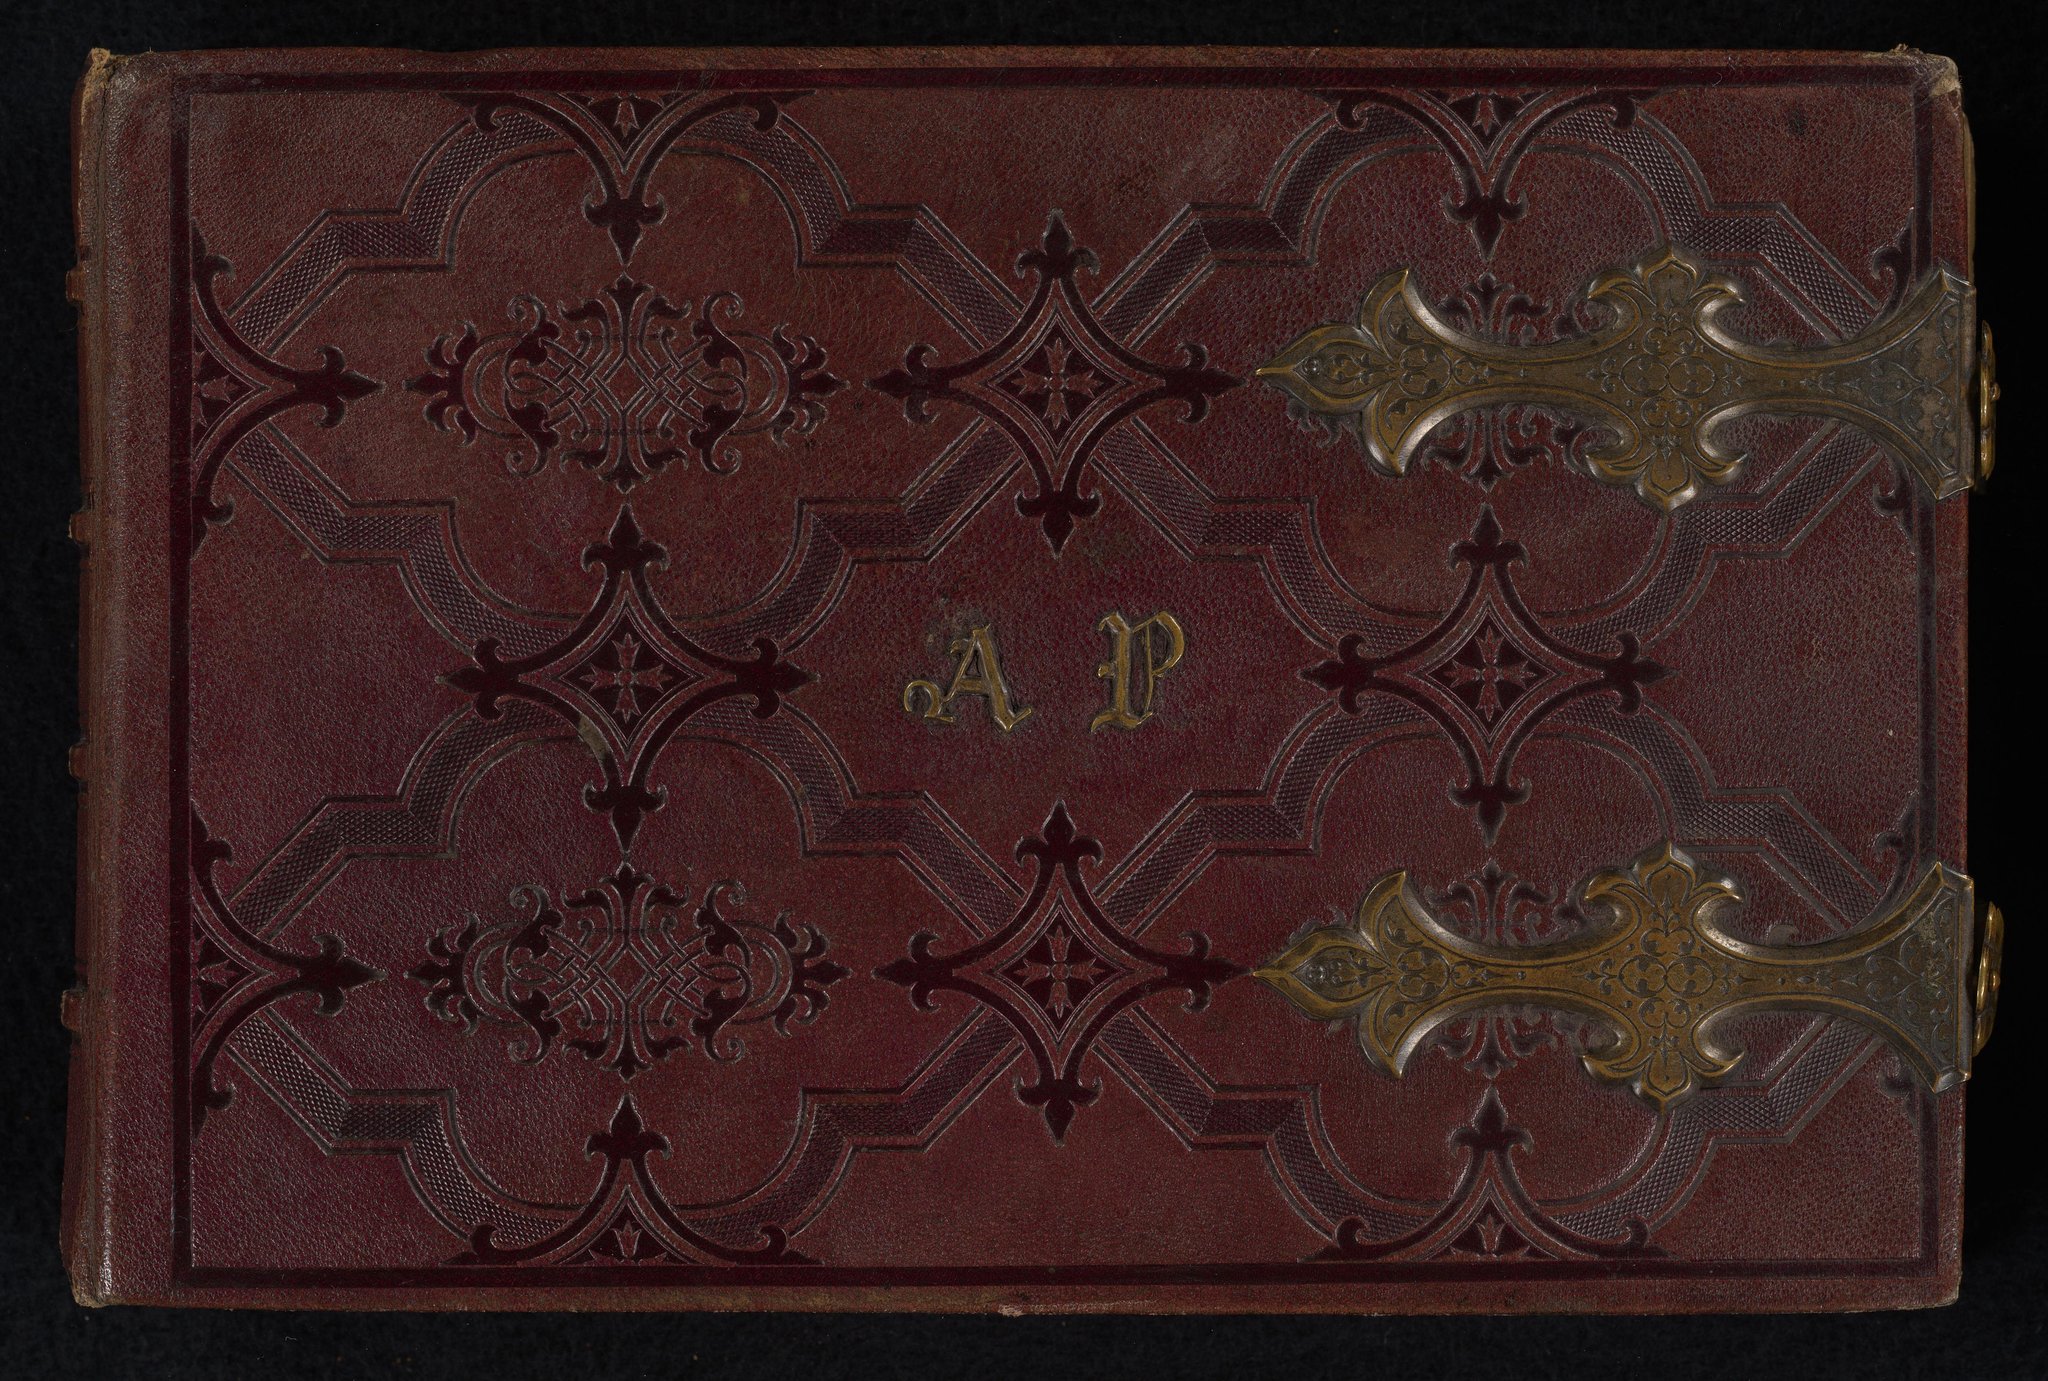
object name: photograph album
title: Fotoalbum met 96 foto's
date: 1855-1900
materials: cardboard, leather, metal, photographic support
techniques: albumen print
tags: sitting figure, adult woman, adult man, historical persons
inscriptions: inscription: ‘Dienst Verspreide Rijkskollekties/ (...)’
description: Fotoalbum met 48 pagina's met in totaal 96 foto's, alle cartes-de-visite. Het album bevat portretten.